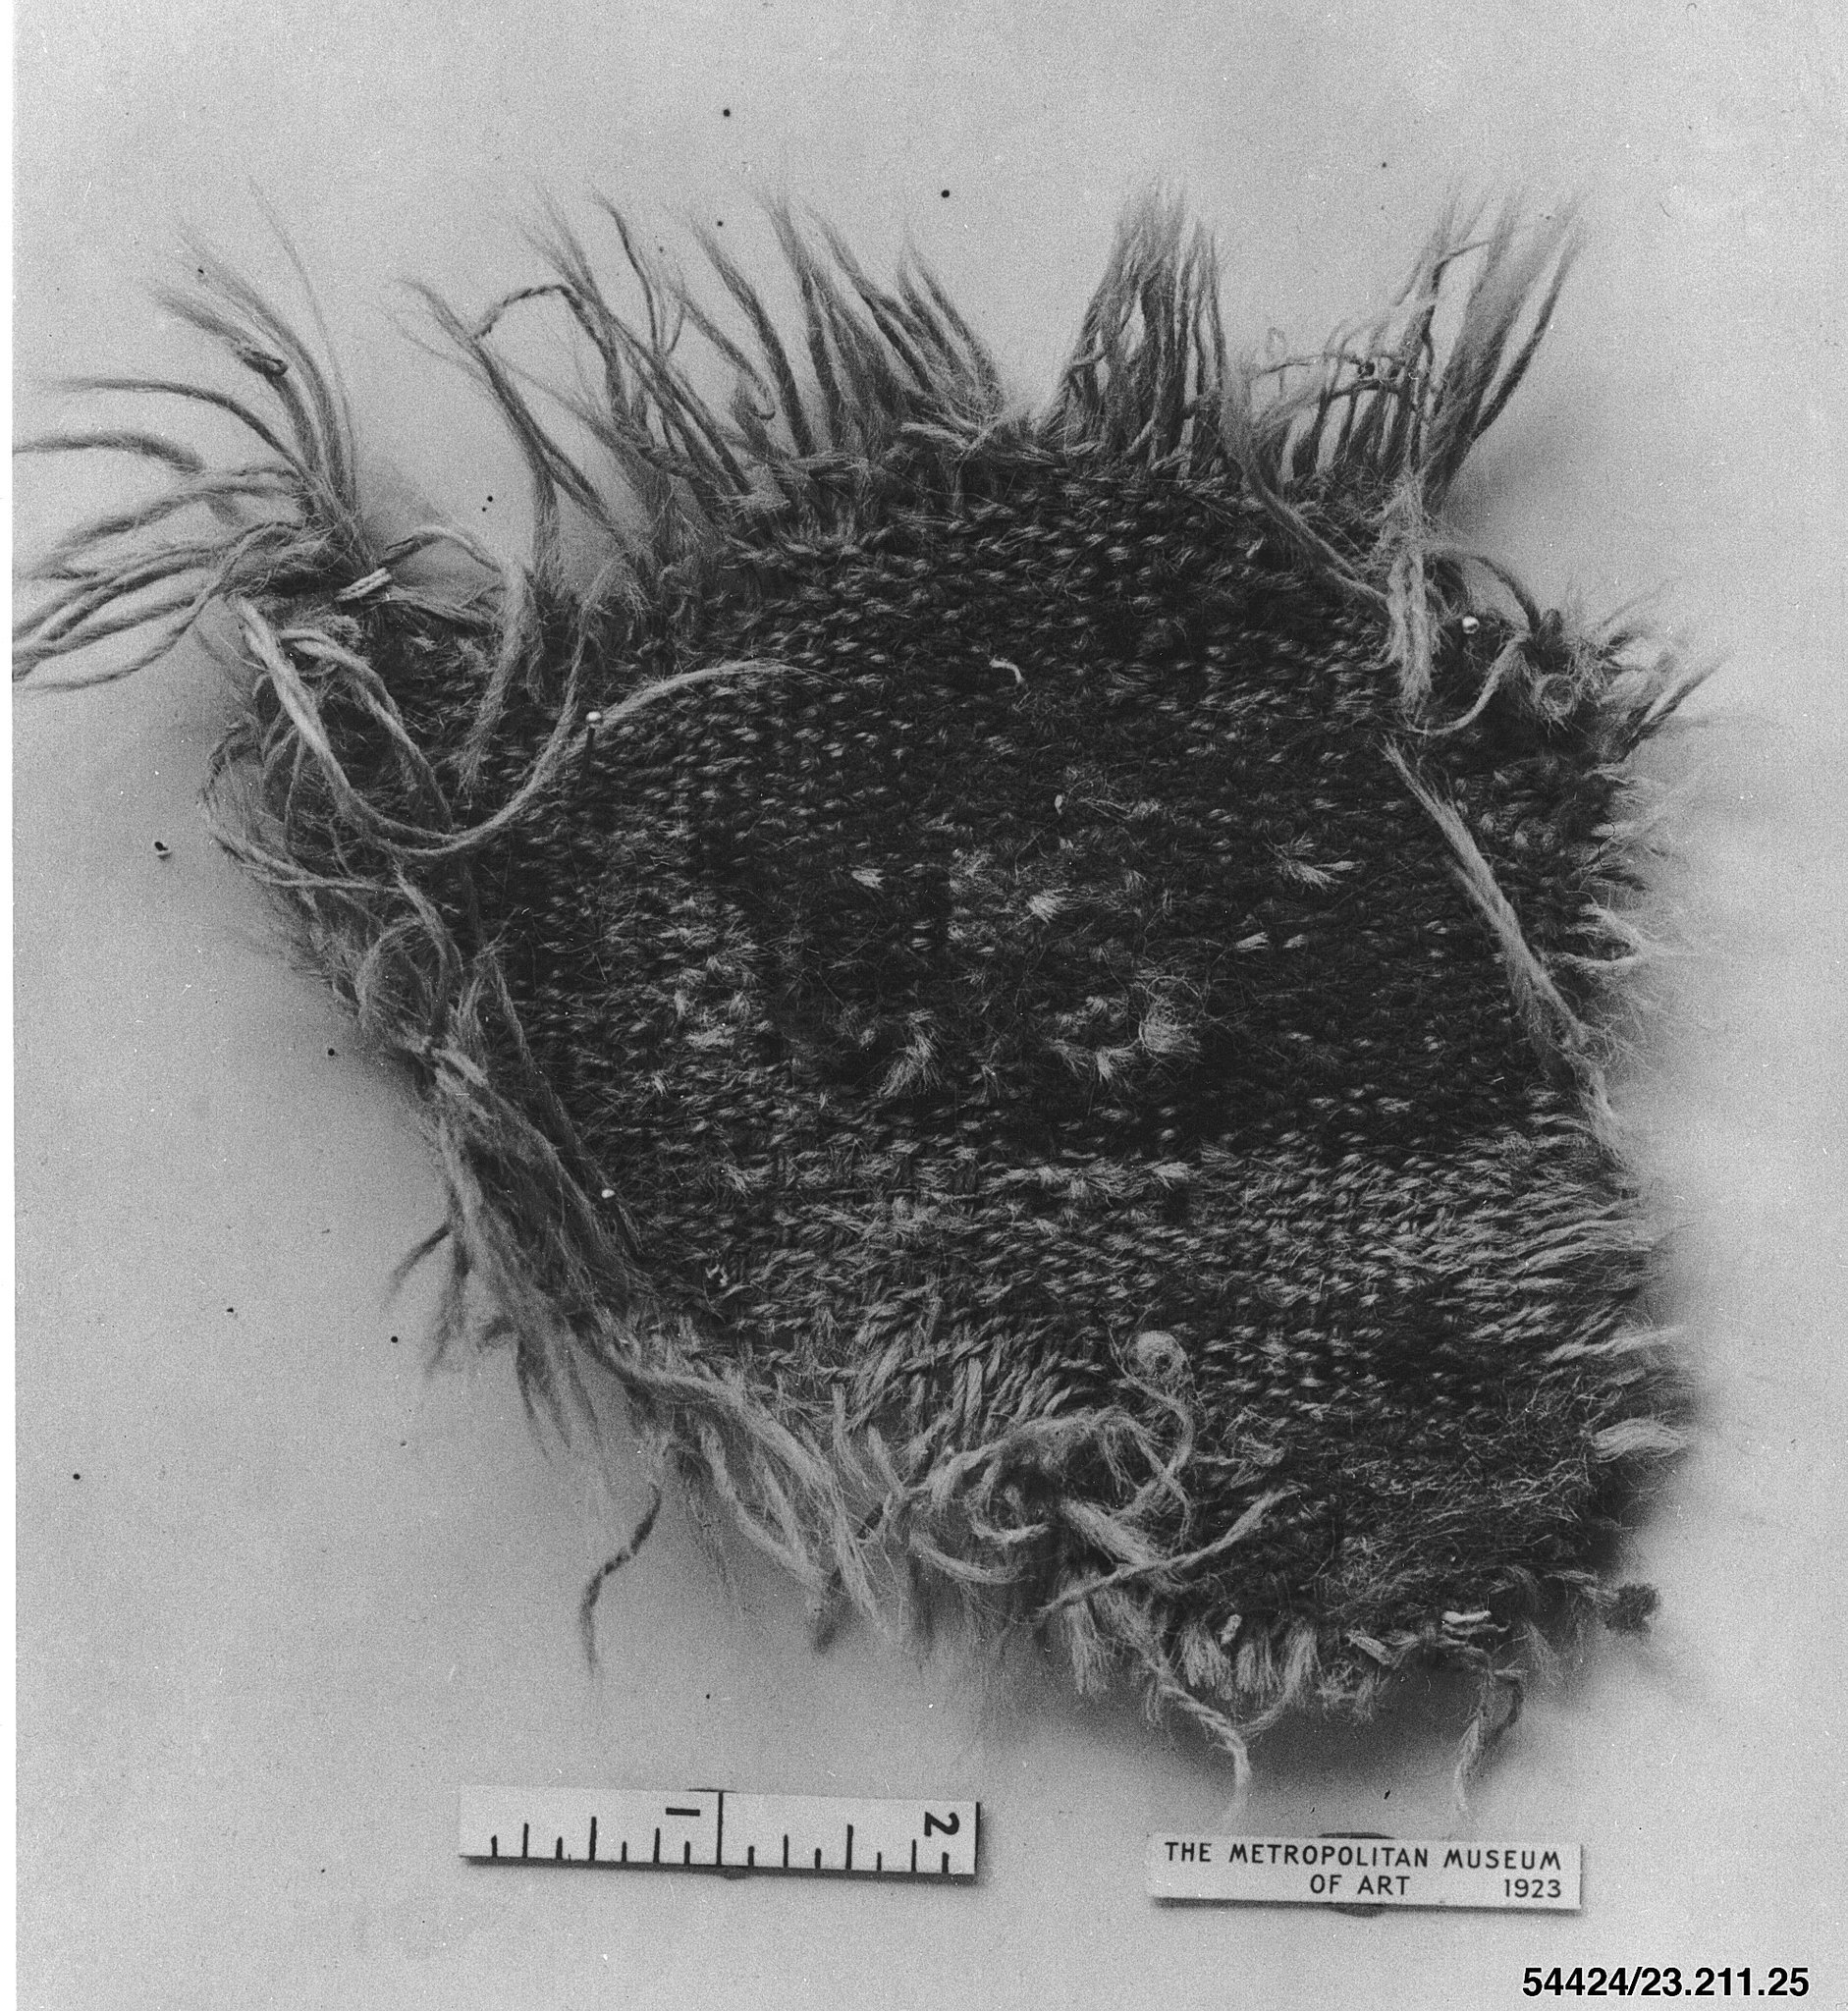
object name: rug fragment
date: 1501-1600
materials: wool